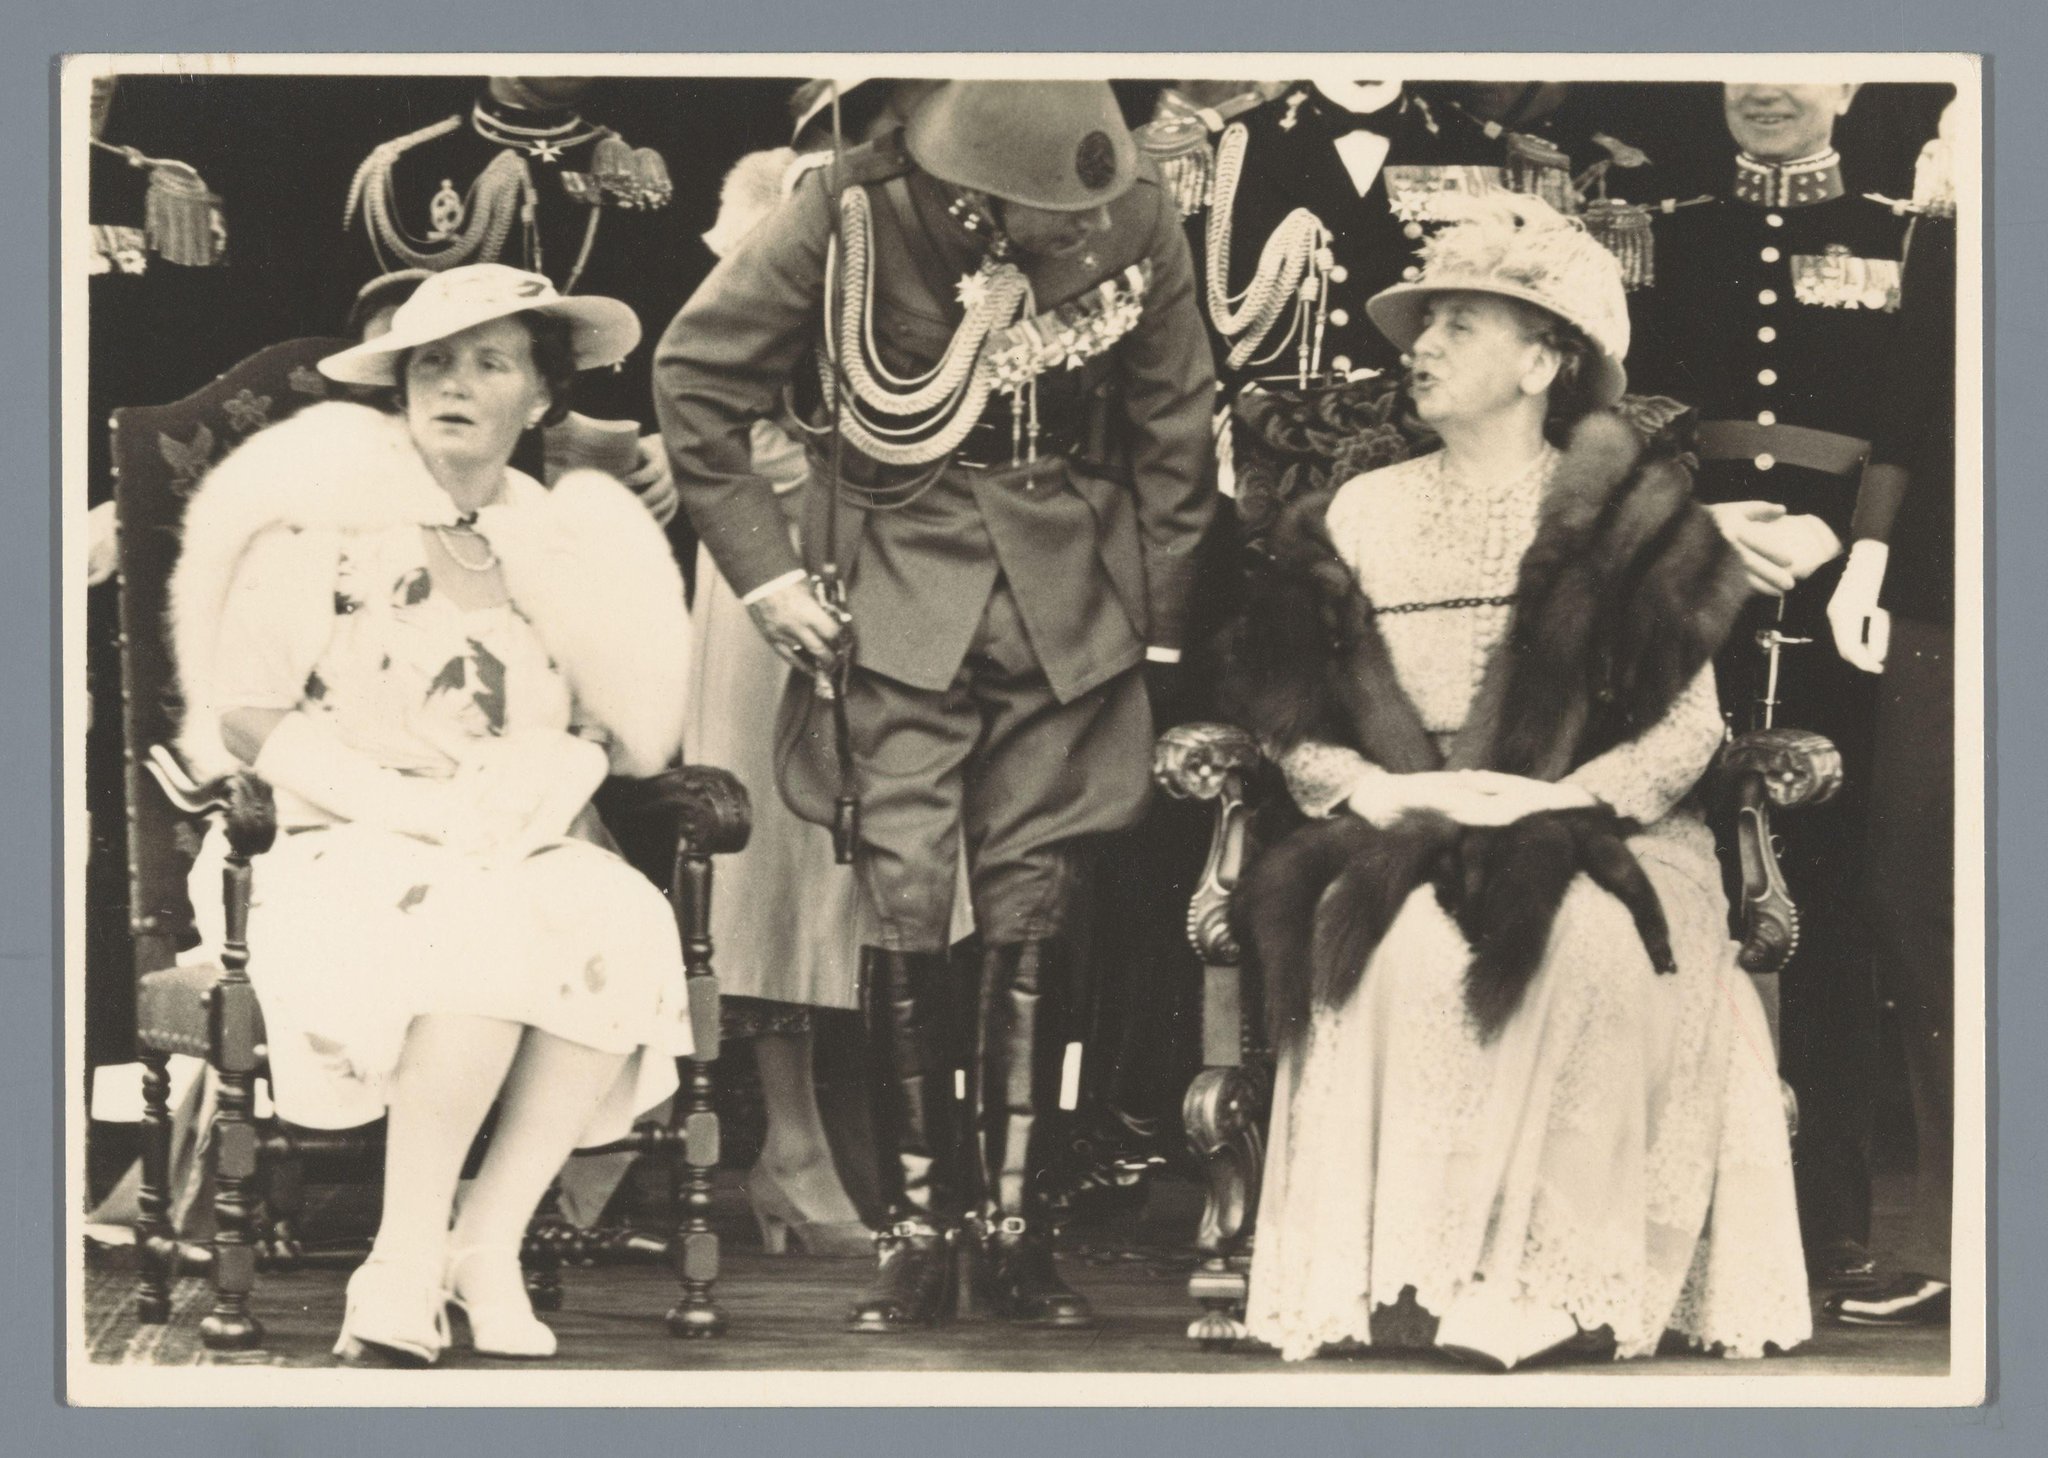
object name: photograph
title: Legerdag in 's-Gravenhage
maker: Anonymous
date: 1938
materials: photographic support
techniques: gelatin silver print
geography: amsterdam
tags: print maker, wilhelmina of the netherlands, juliana of the netherlands, crown princess, queen, the hague